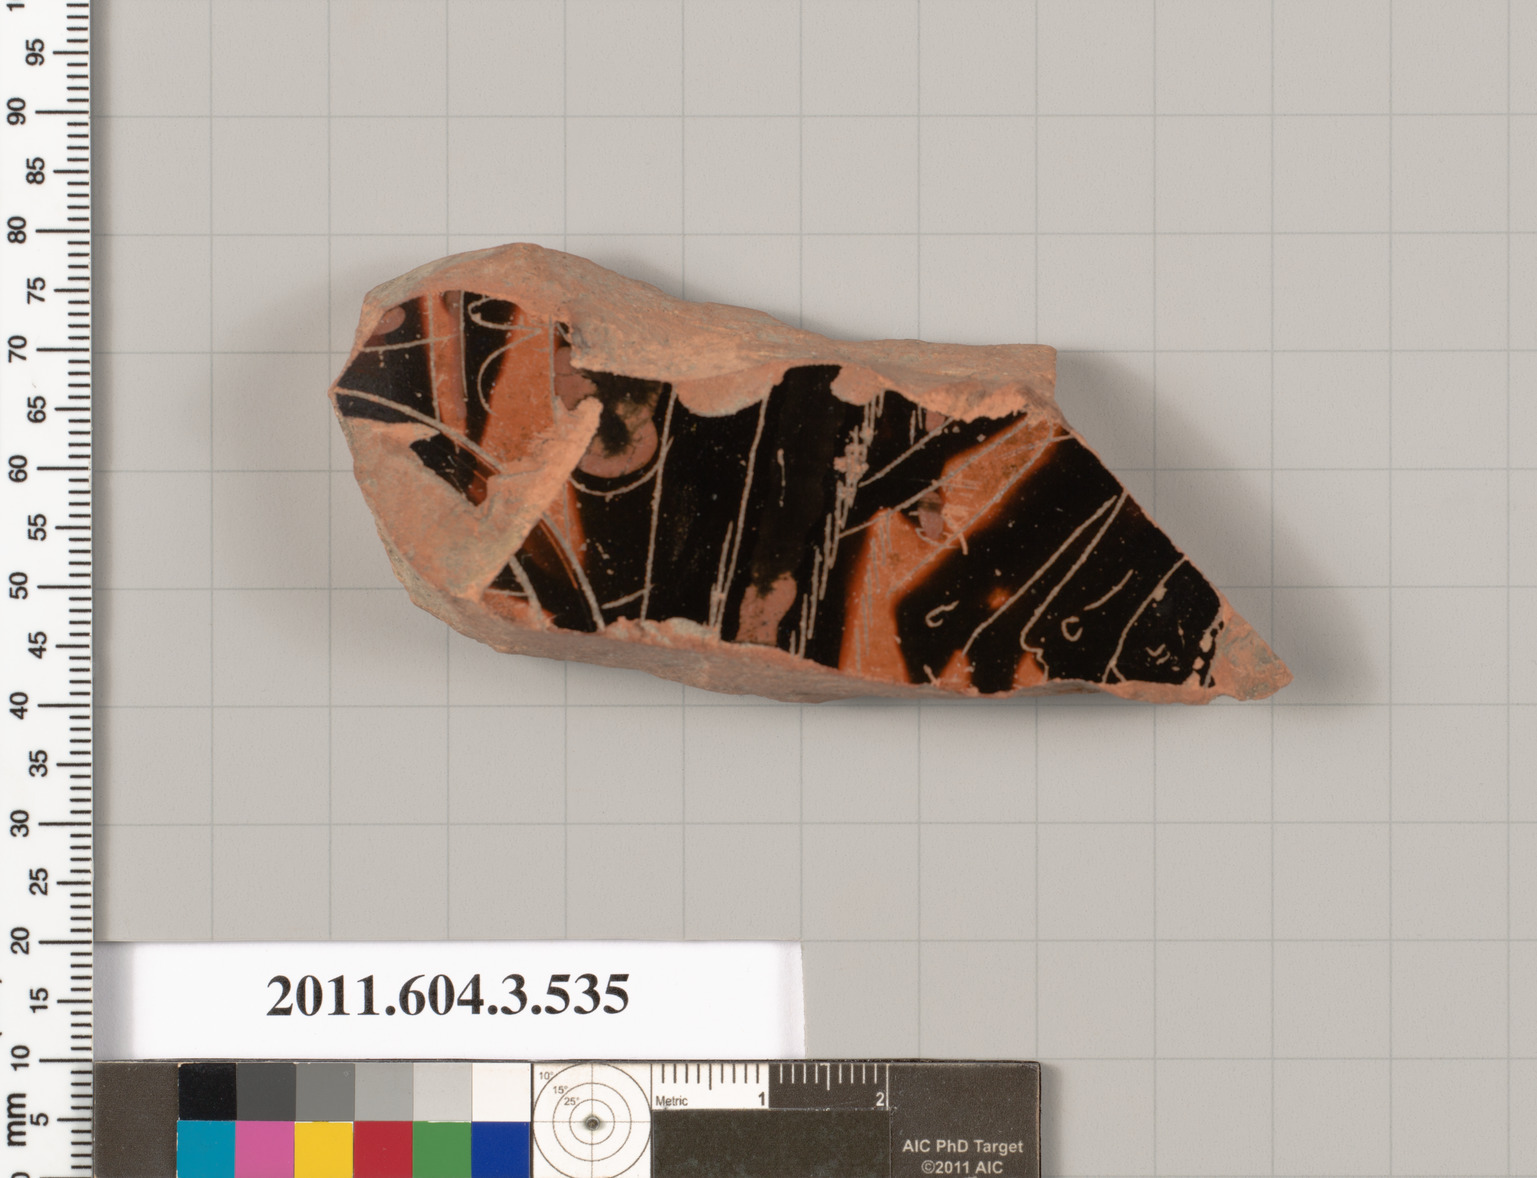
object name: calyx krater or column krater fragment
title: Terracotta fragment of a column-krater (bowl for mixing wine and water) or a calyx-krater (bowl for mixing wine and water)?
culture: greek, attic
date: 534-468 BCE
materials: terracotta